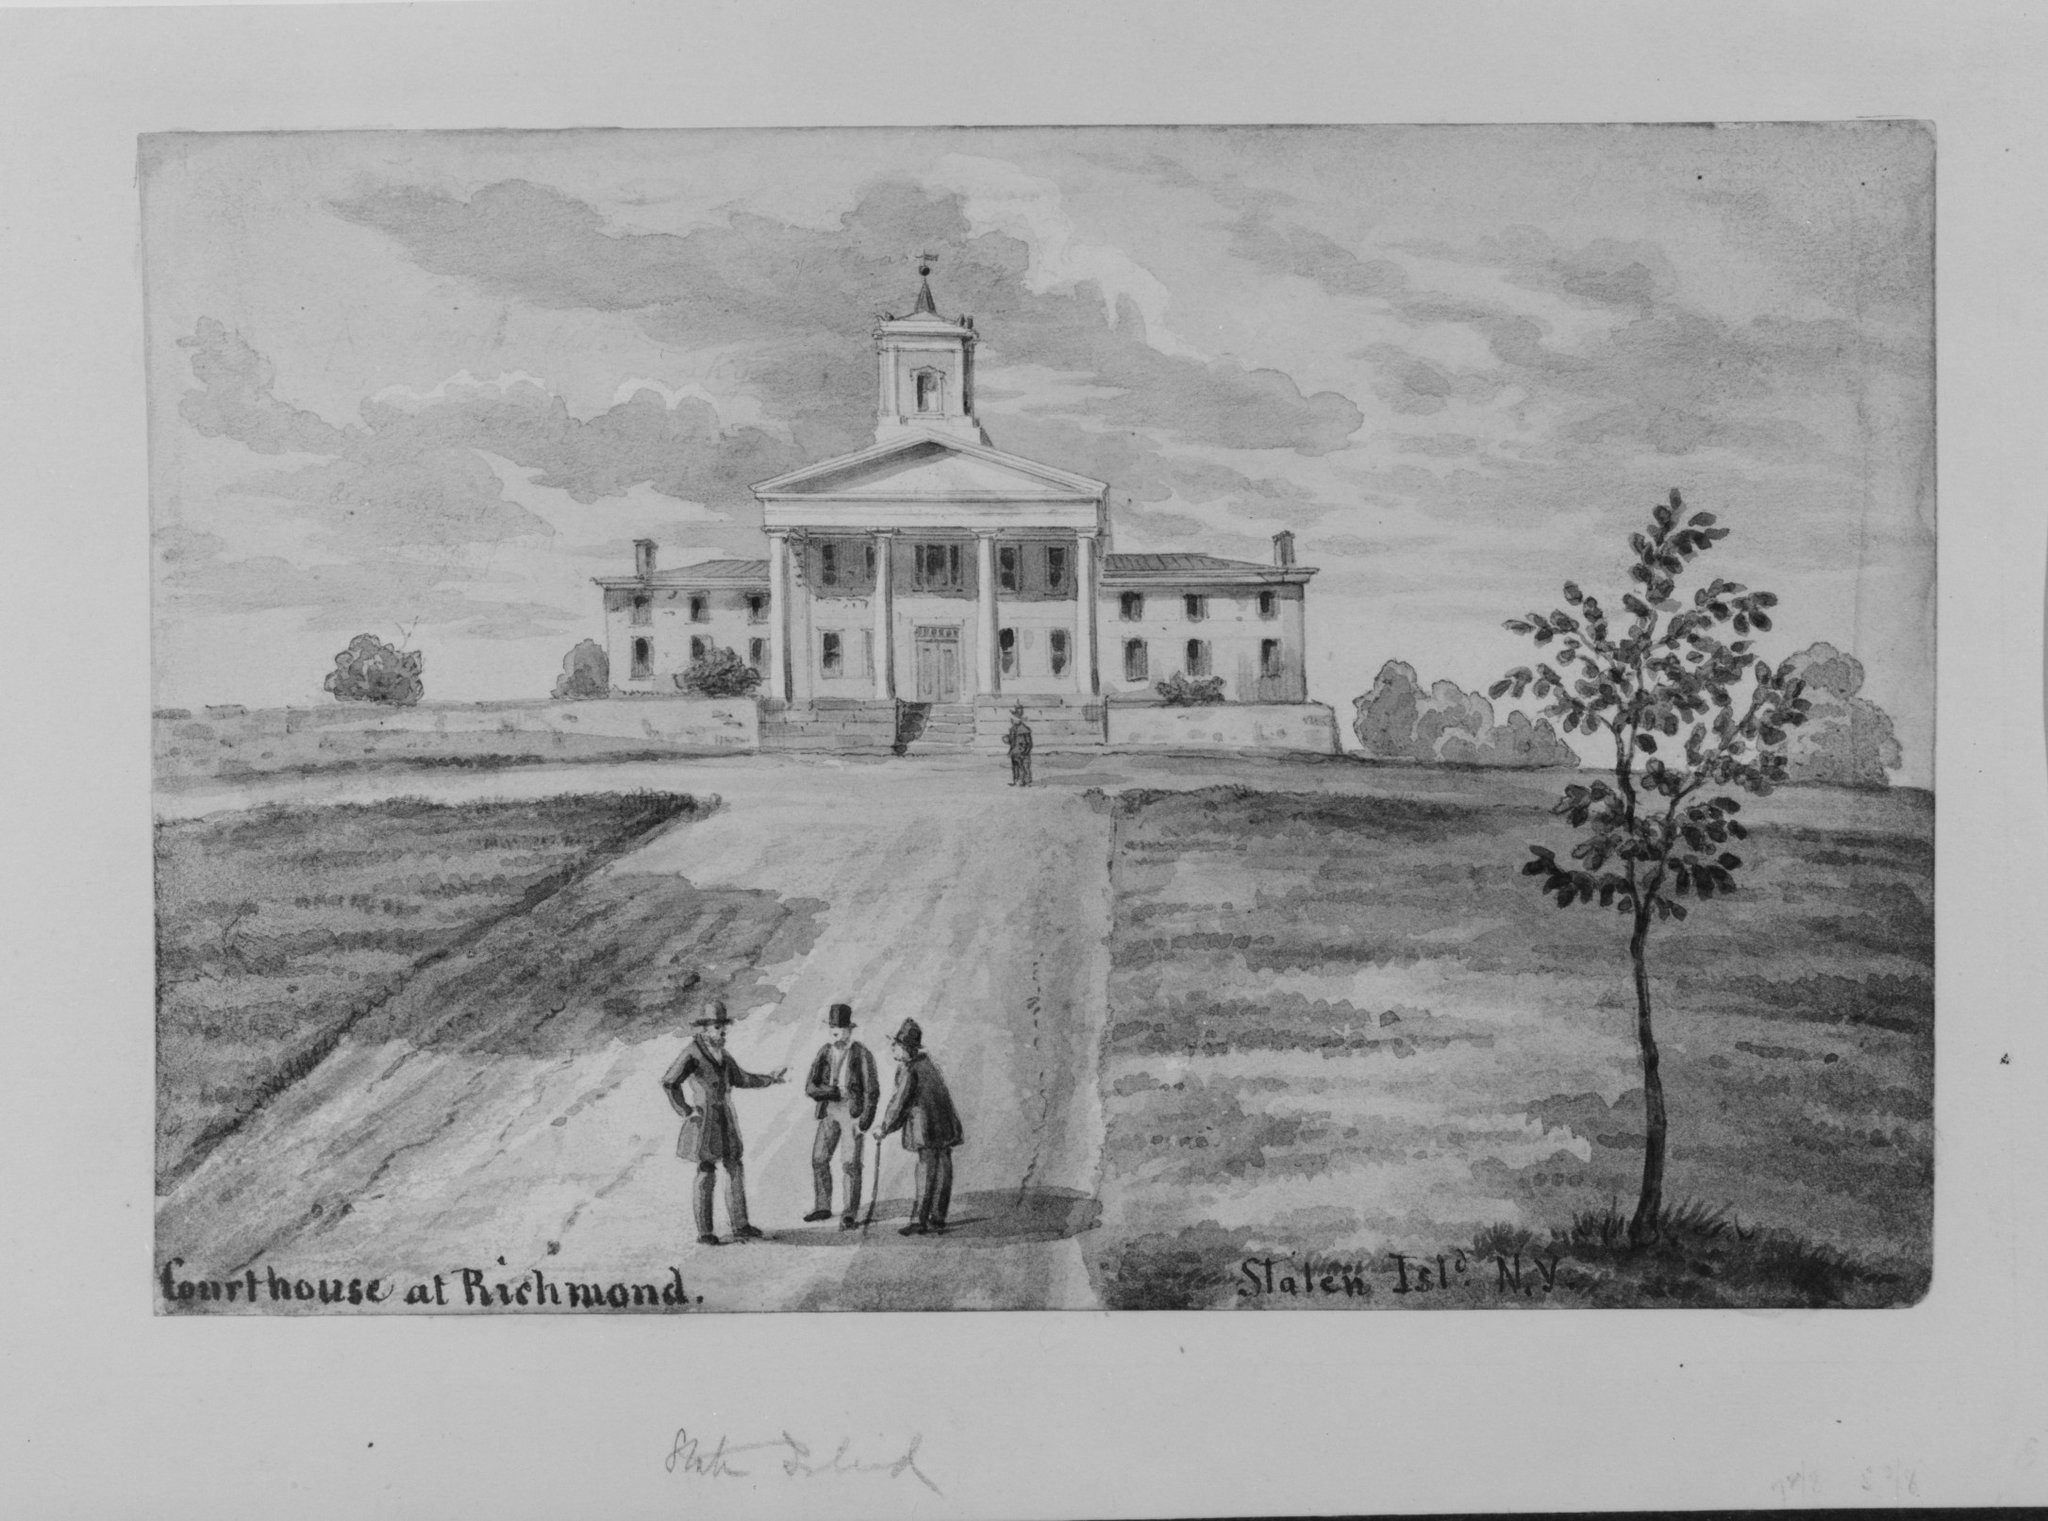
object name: drawing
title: Courthouse at Richmond, Staten Island, New York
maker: augustus kollner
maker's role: artist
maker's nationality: american, born germany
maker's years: 1812-1906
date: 1872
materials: watercolor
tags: buildings,new york city